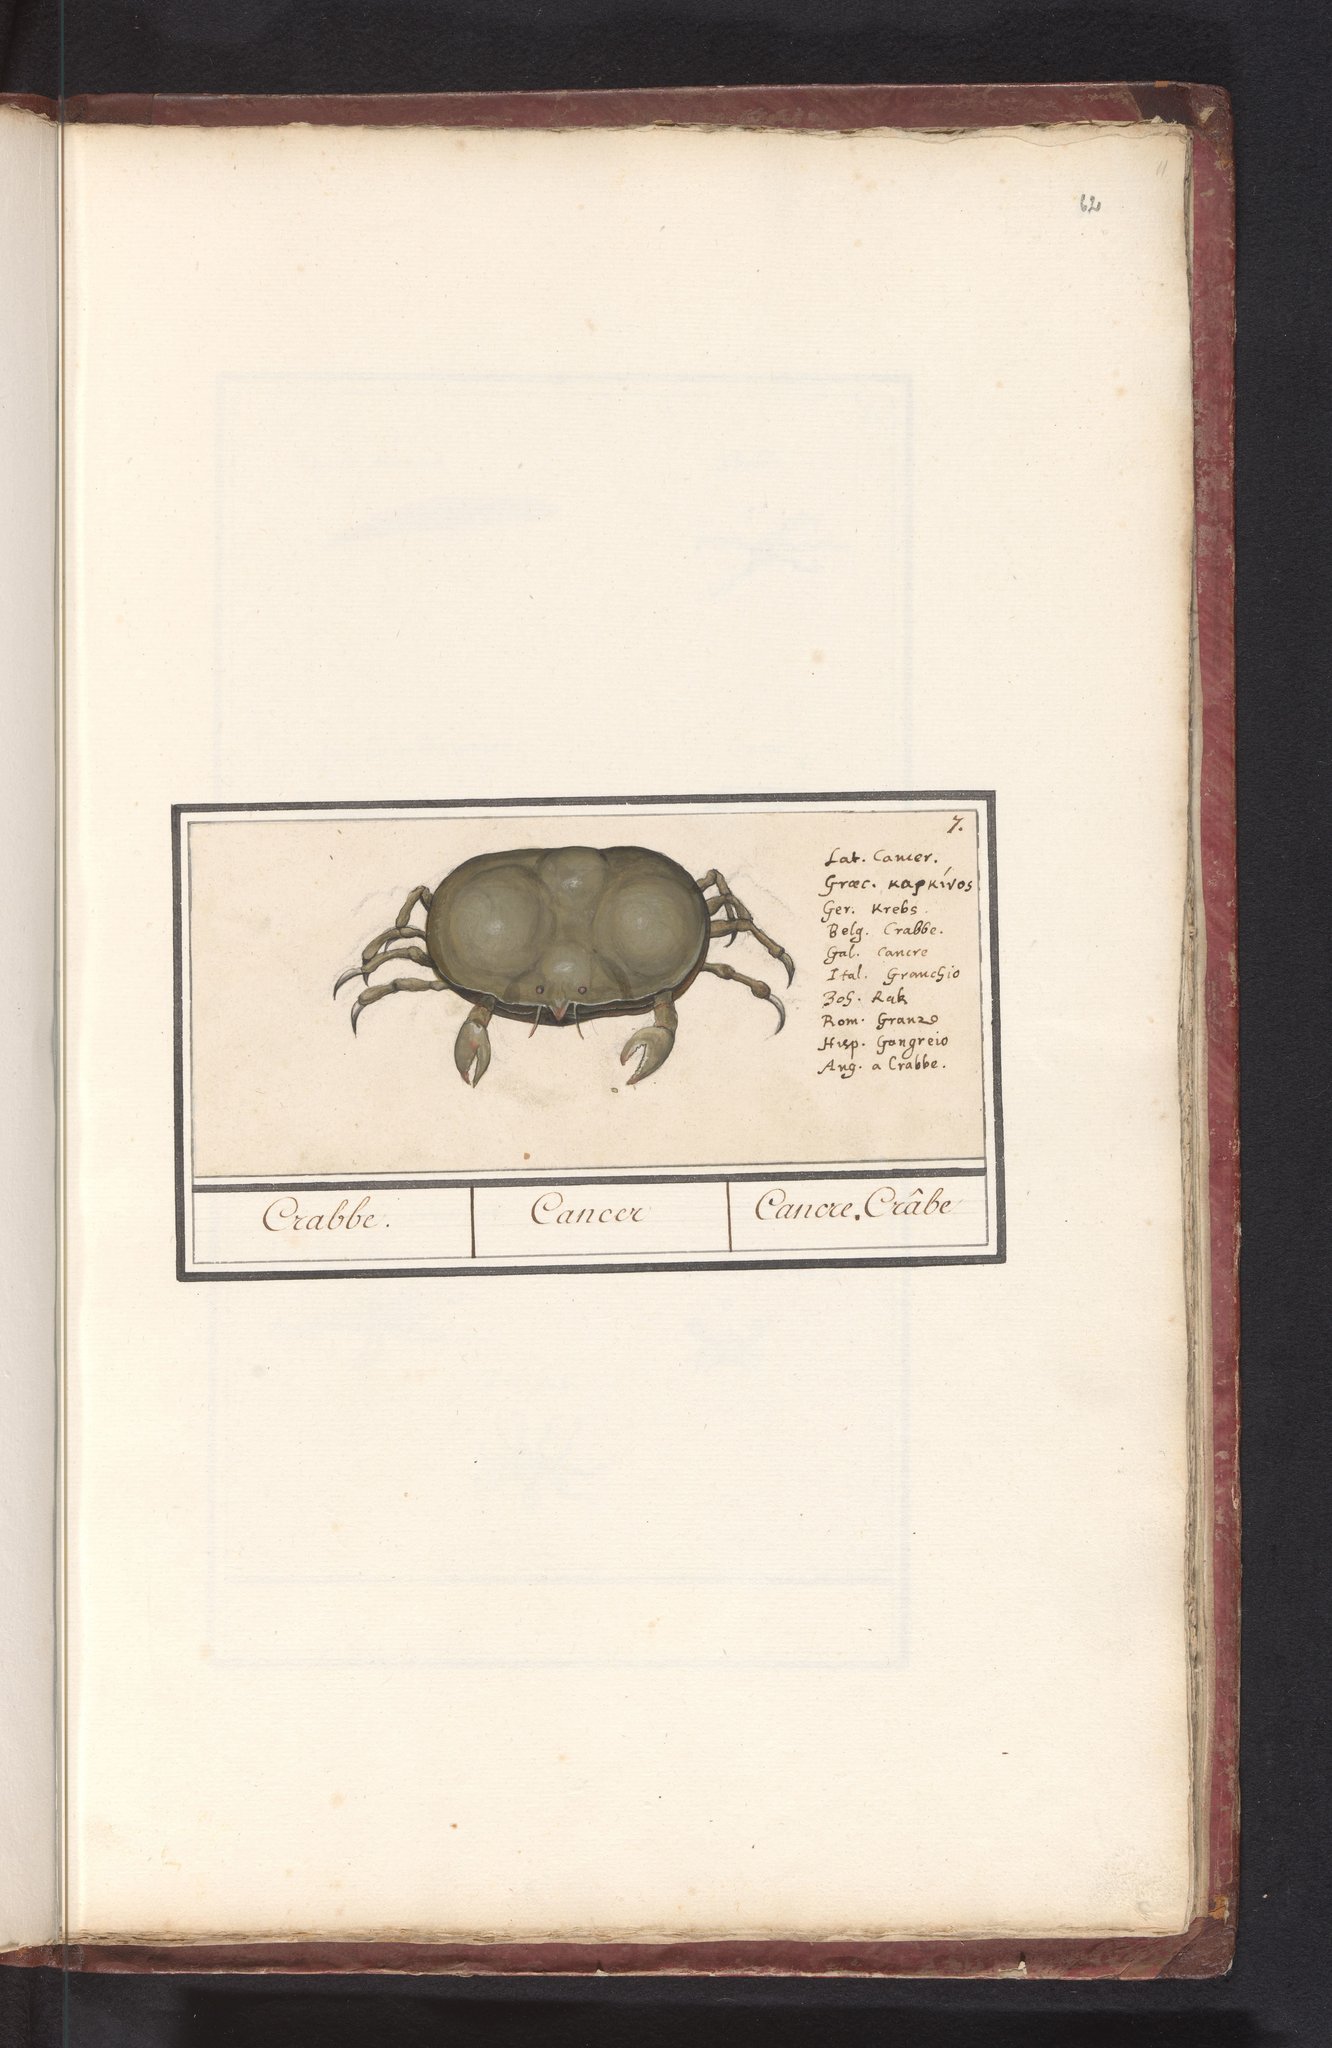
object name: drawing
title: Krab (Cancer)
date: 1596-1610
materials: chalk, paint, ink, lacquer, paper, pencil, watercolor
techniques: brush, pen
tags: crustaceans: crab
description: Krab. Genummerd rechtsboven: 7. Daaronder de naam in tien talen. Onderdeel van het zesde album met tekeningen van vissen, schelpen en insekten. Zesde van twaalf albums met tekeningen van dieren, vogels en planten bekend rond 1600, gemaakt in opdracht van keizer Rudolf II. Met toelichting in Nederlands, Latijn en Frans.